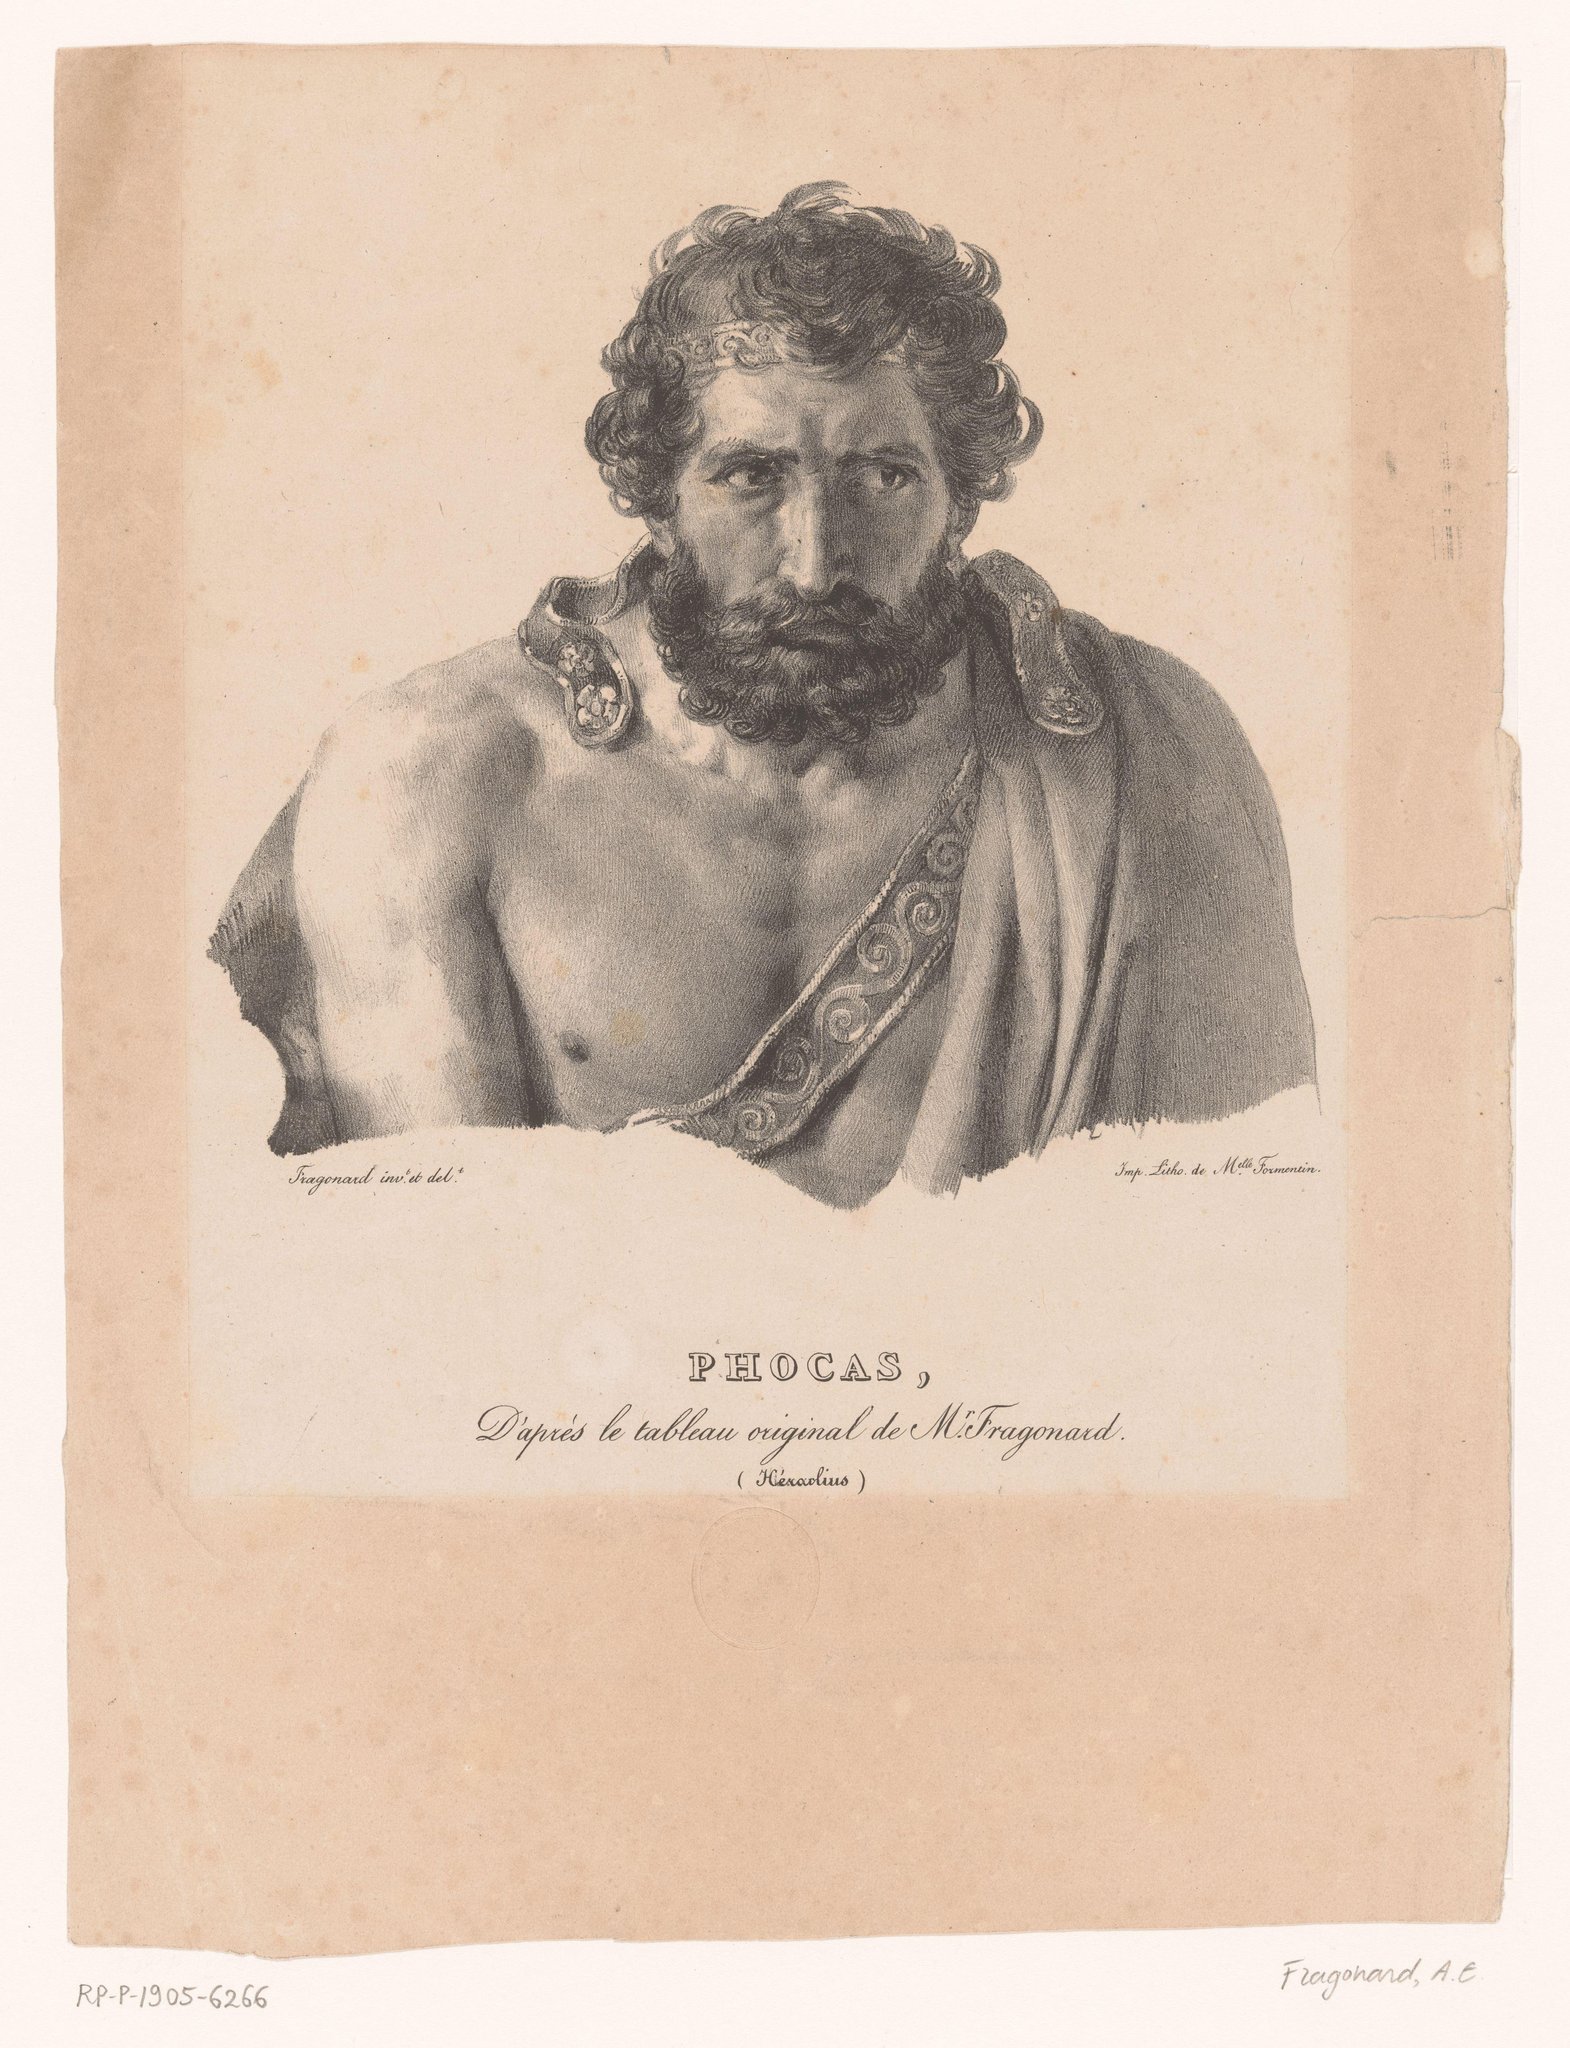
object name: print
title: Portret van keizer Flavius Phocas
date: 1824-1826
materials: paper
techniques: lithograph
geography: paris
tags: historical persons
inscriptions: collector's mark: Lugt 2228a, check stamp: Lugt 3431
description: Phocas is afgebeeld als personage uit de tragedie Héraclius van Pierre Corneille.